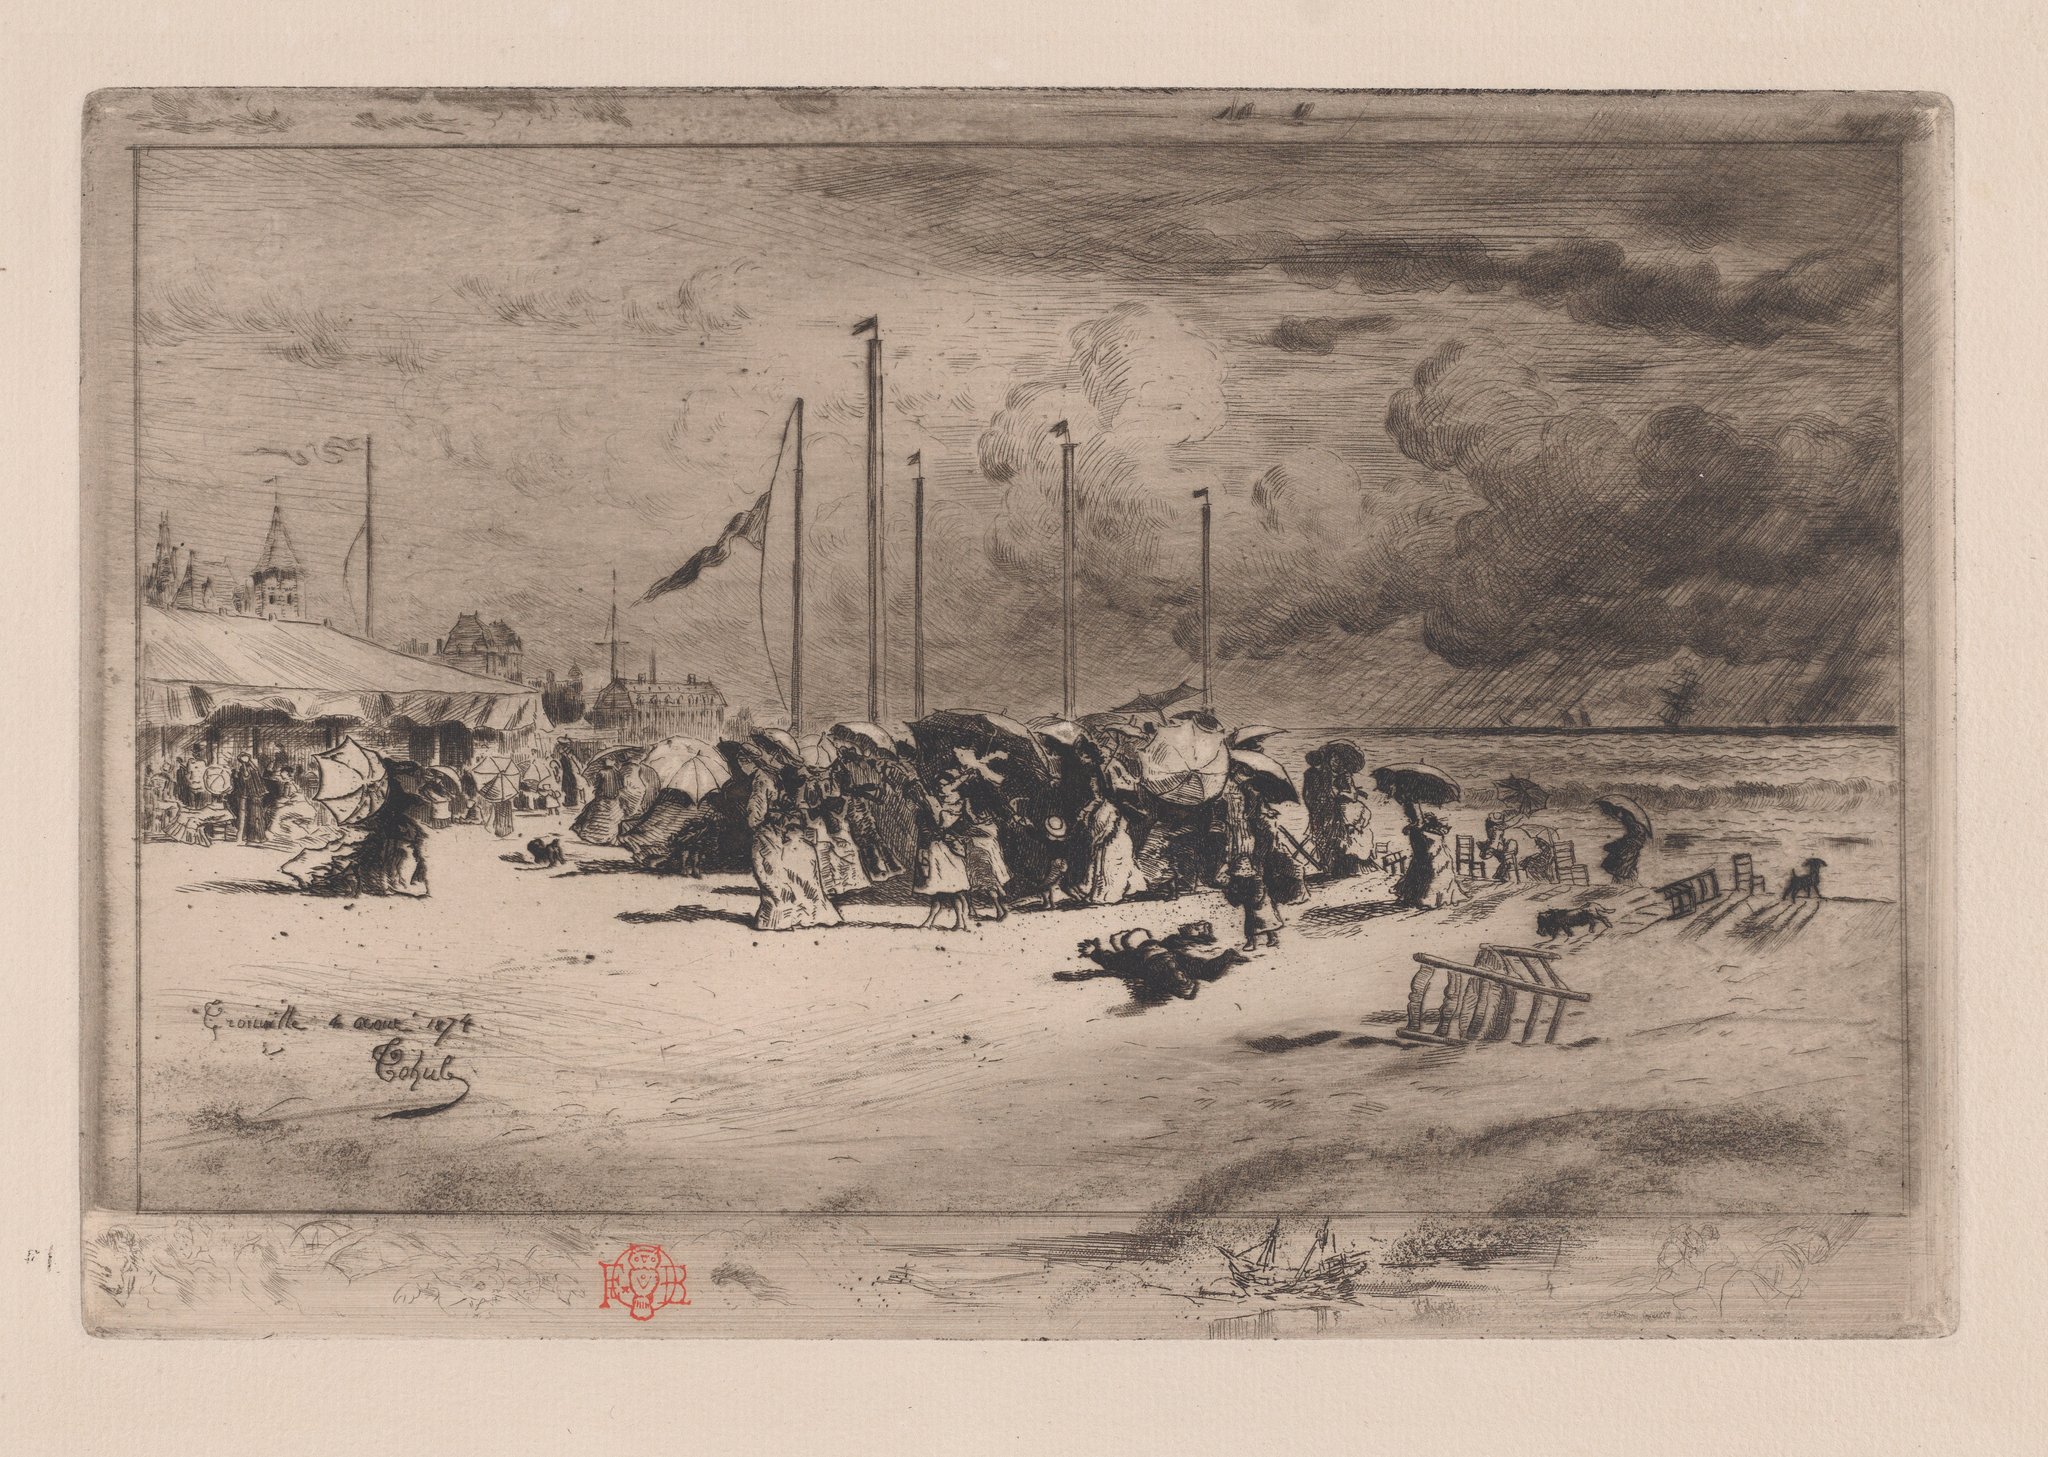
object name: print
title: A Squall at Trouville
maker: félix-hilaire buhot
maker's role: artist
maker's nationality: french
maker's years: 1847-1898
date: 1874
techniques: aquatint, etching, roulette